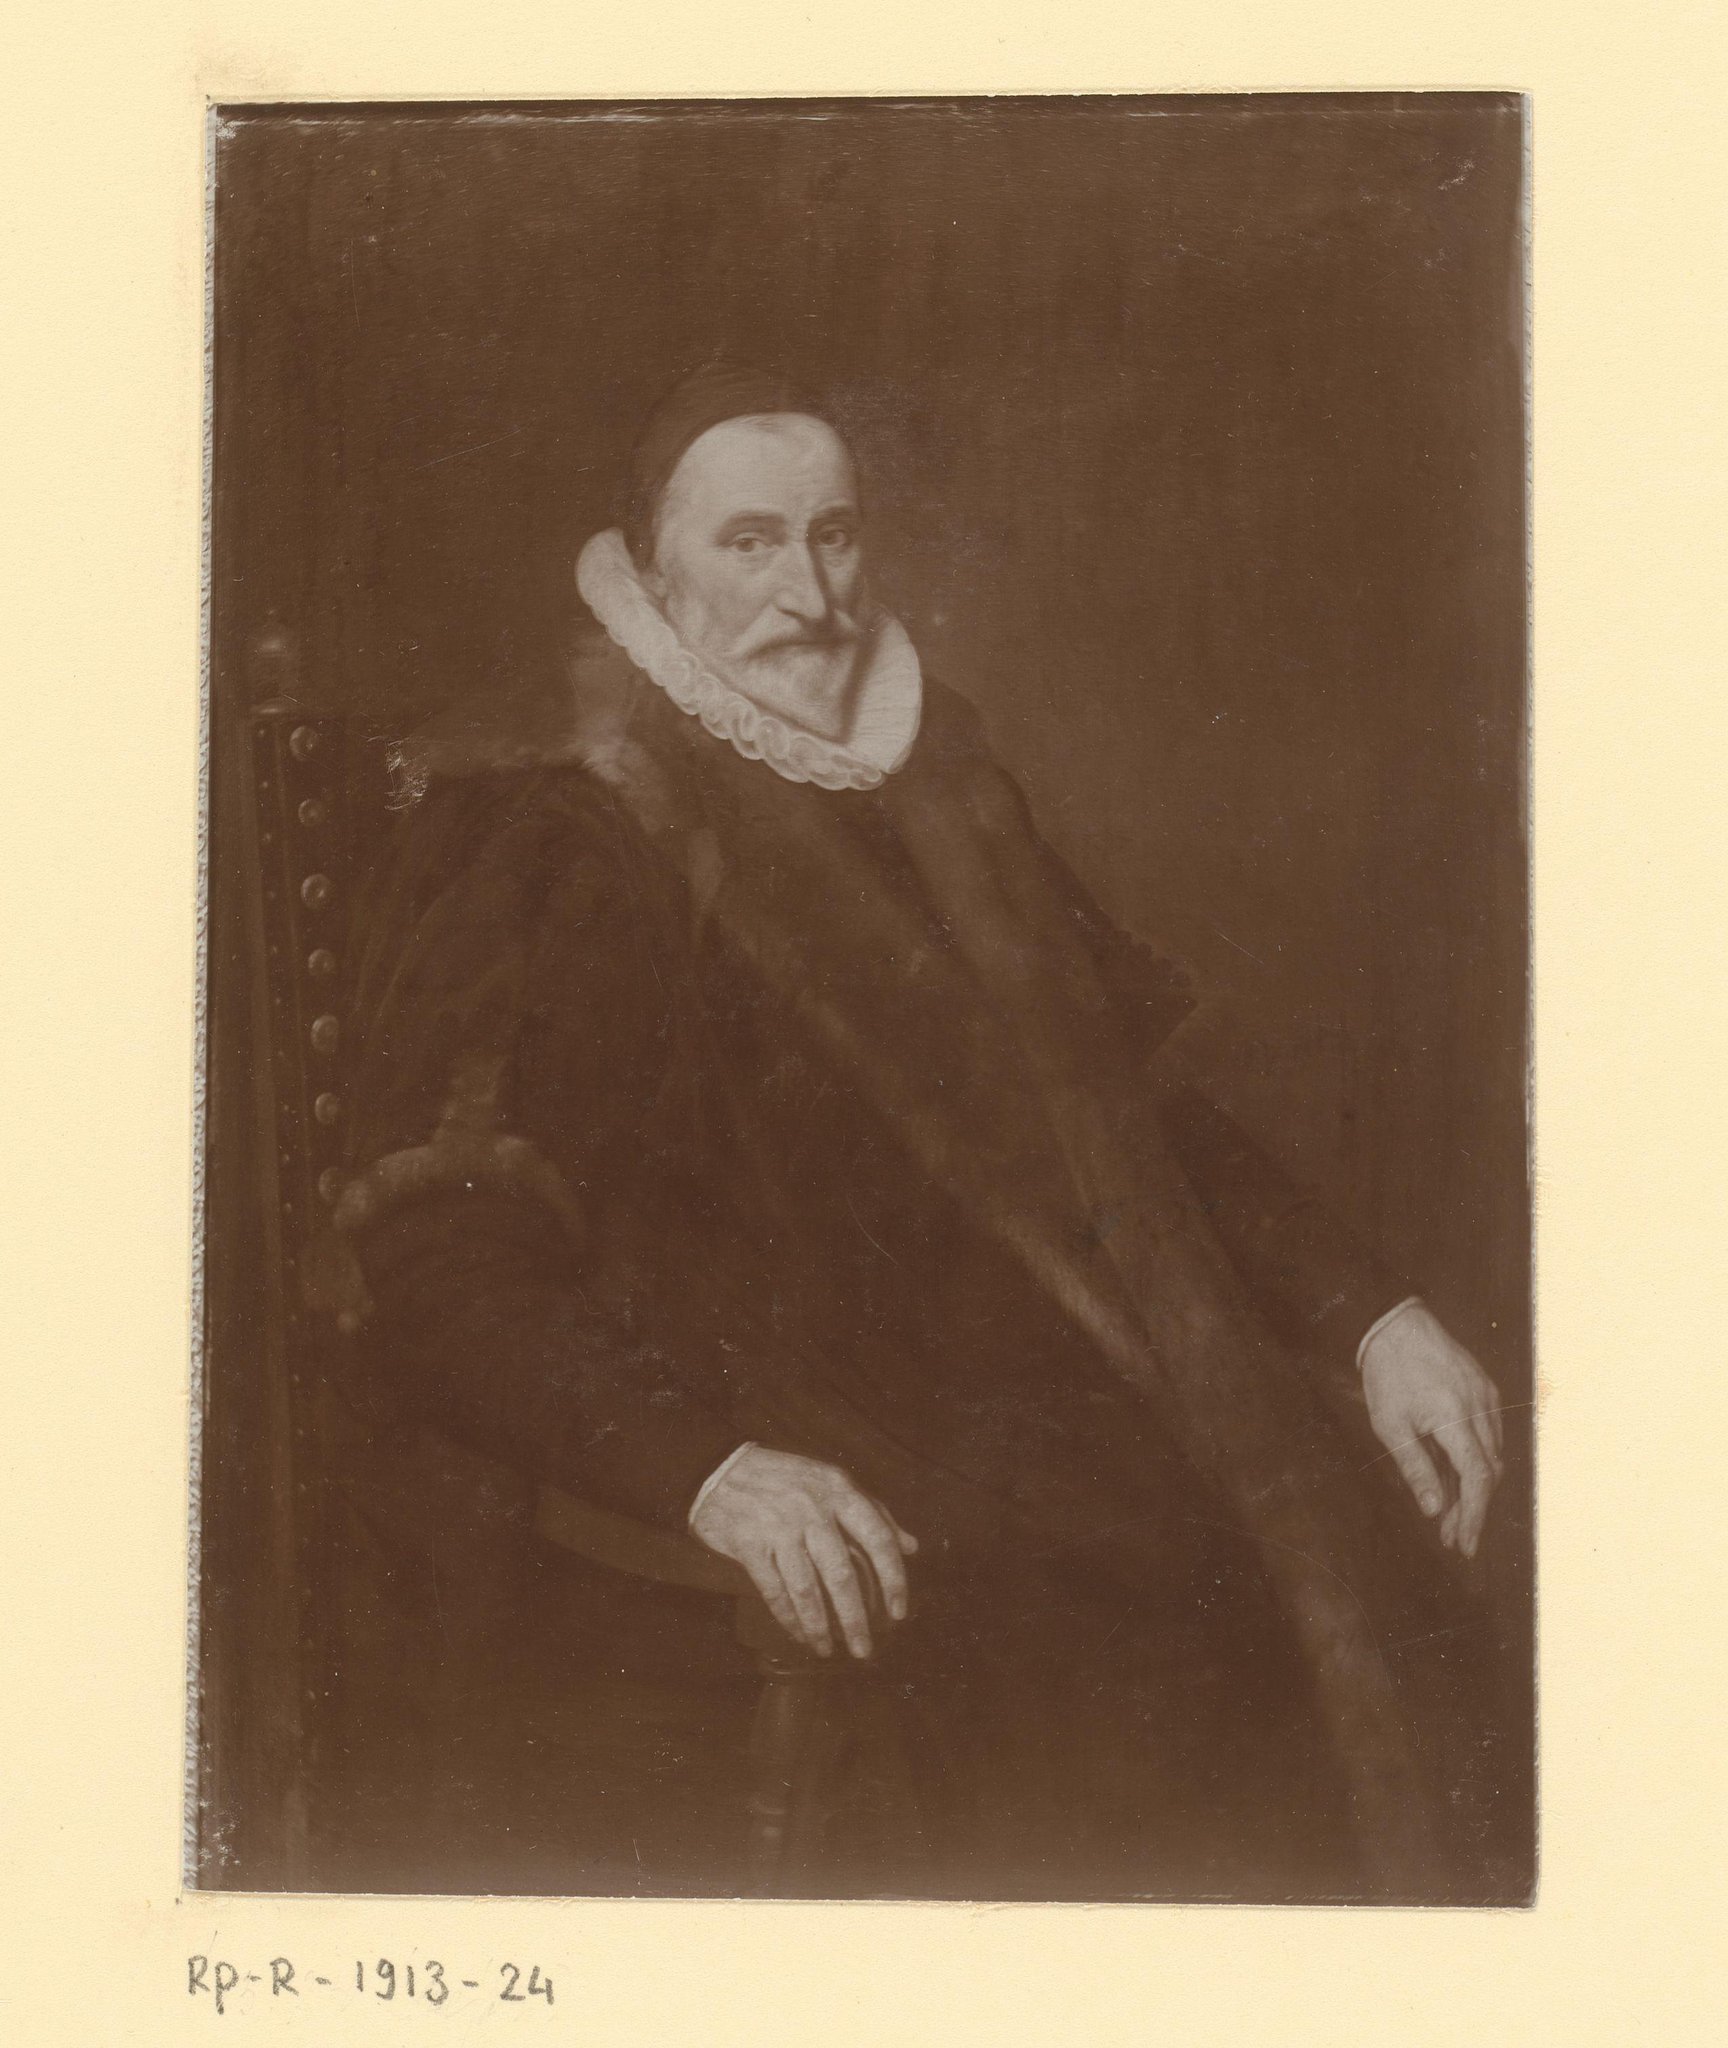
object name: reproduction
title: Fotoreproductie van een geschilderd portret van Cornelis Pieterz. Hooft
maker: Anonymous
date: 1880-1900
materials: paper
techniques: collodion silver print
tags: amsterdam, mayor, cornelis pietersz. hooft, historical persons, picture, painting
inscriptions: inscription: ‘C. v.d. Voort/ N 2591/ RM/ Corn Pieterz Hooft’